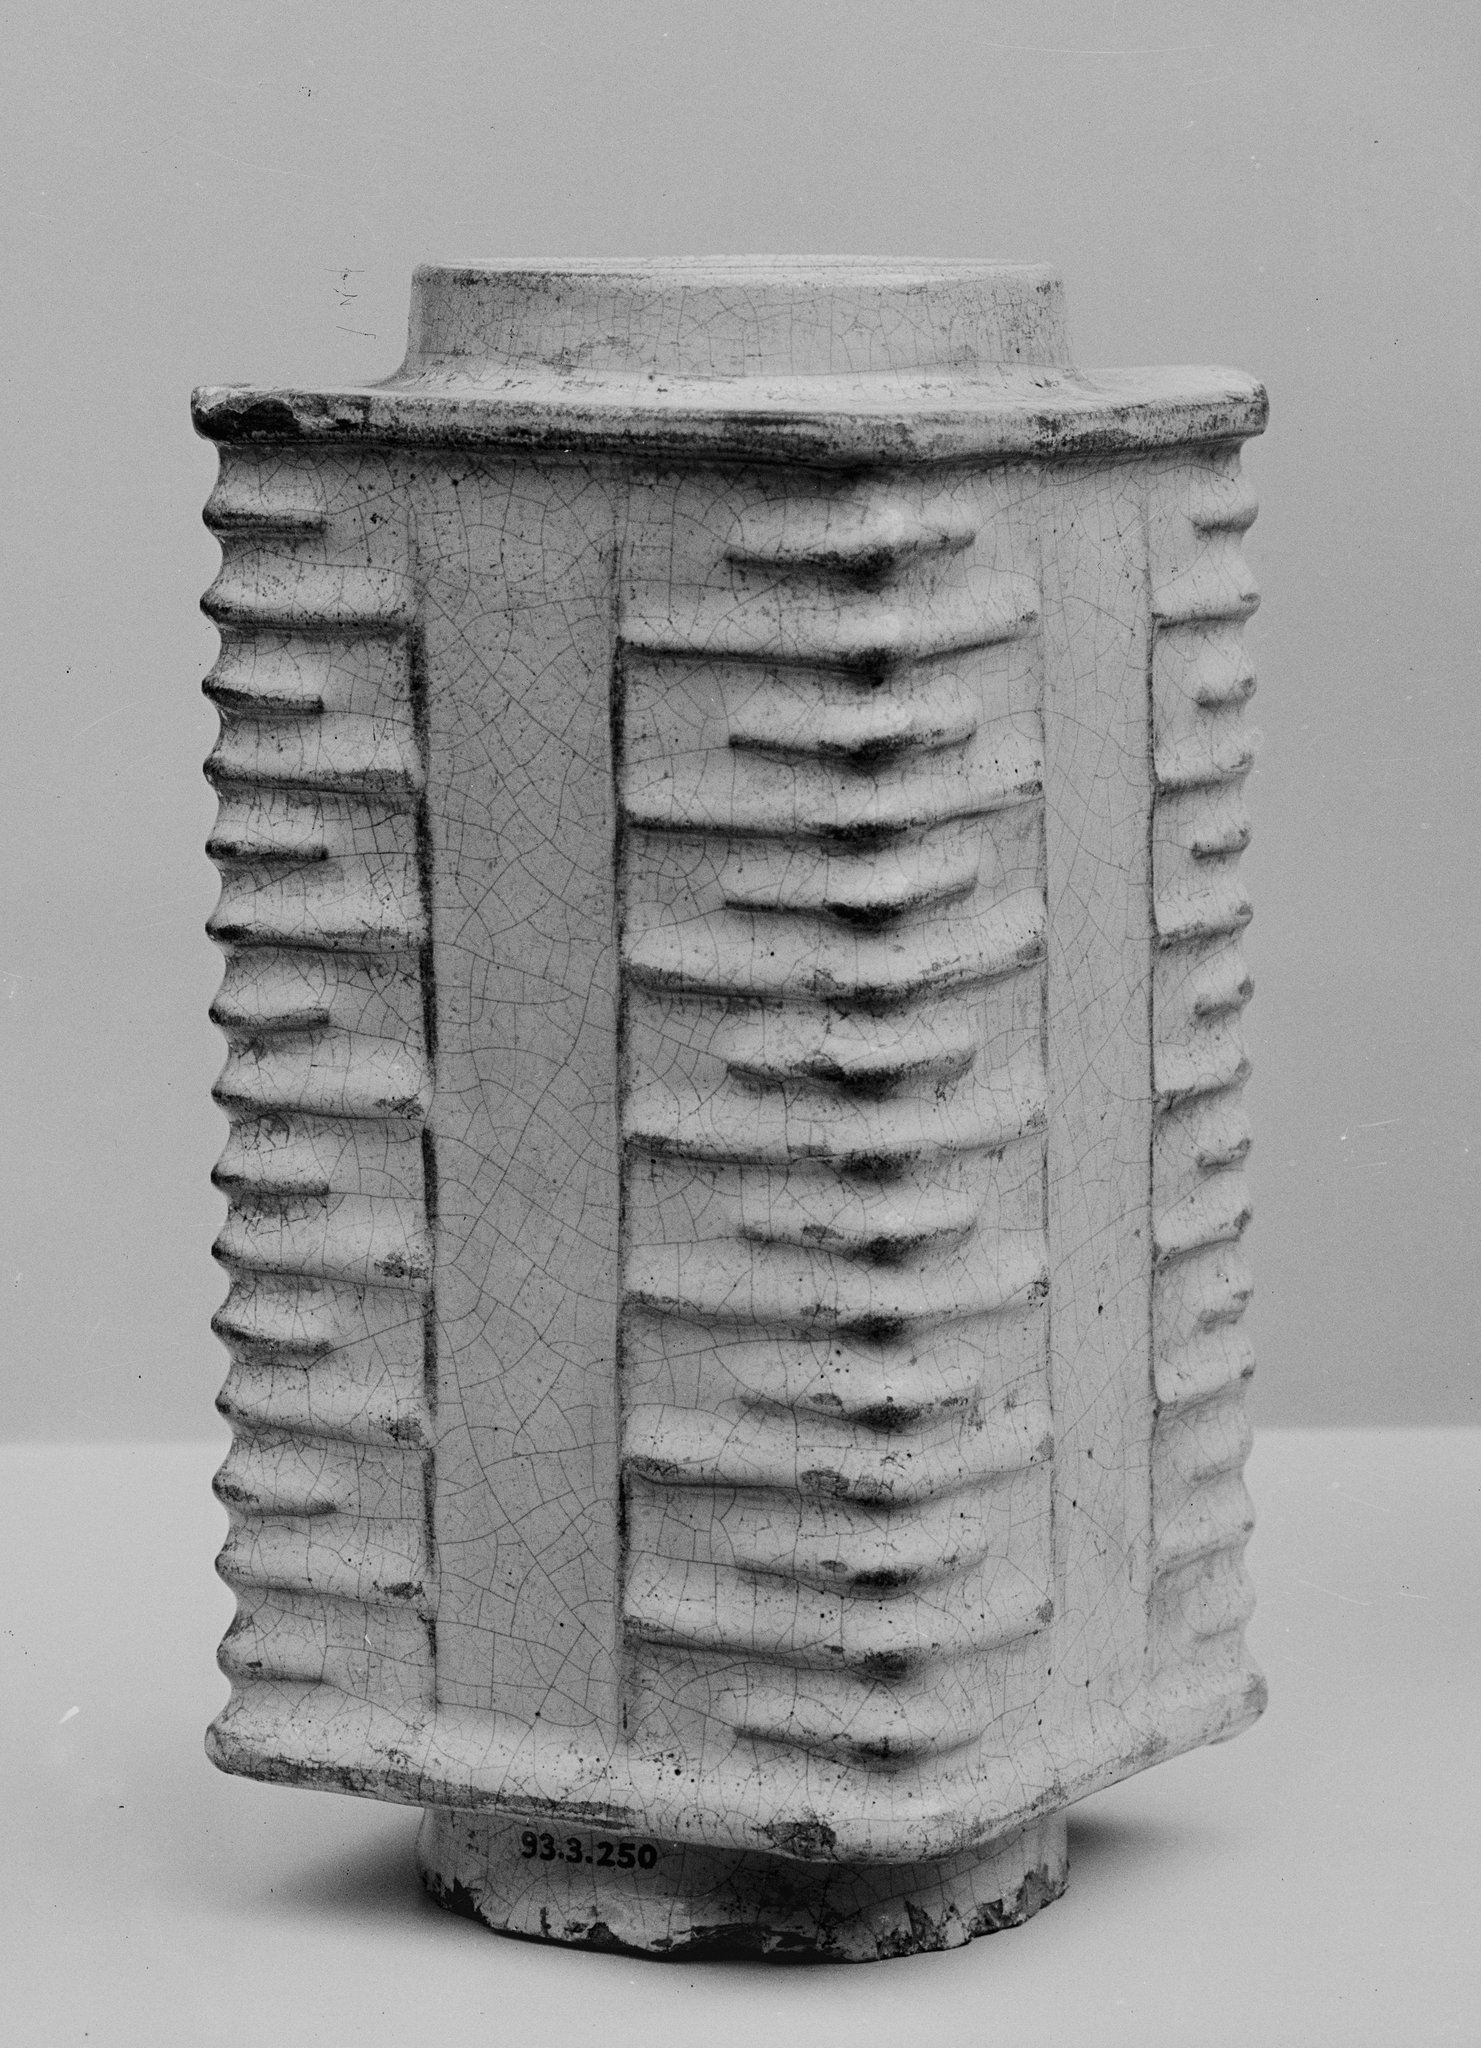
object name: holder for magic straw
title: Quadrangular vase in the form of a Neolithic ritual jade object (cong)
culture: chinese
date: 1801-1900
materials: glaze, stoneware